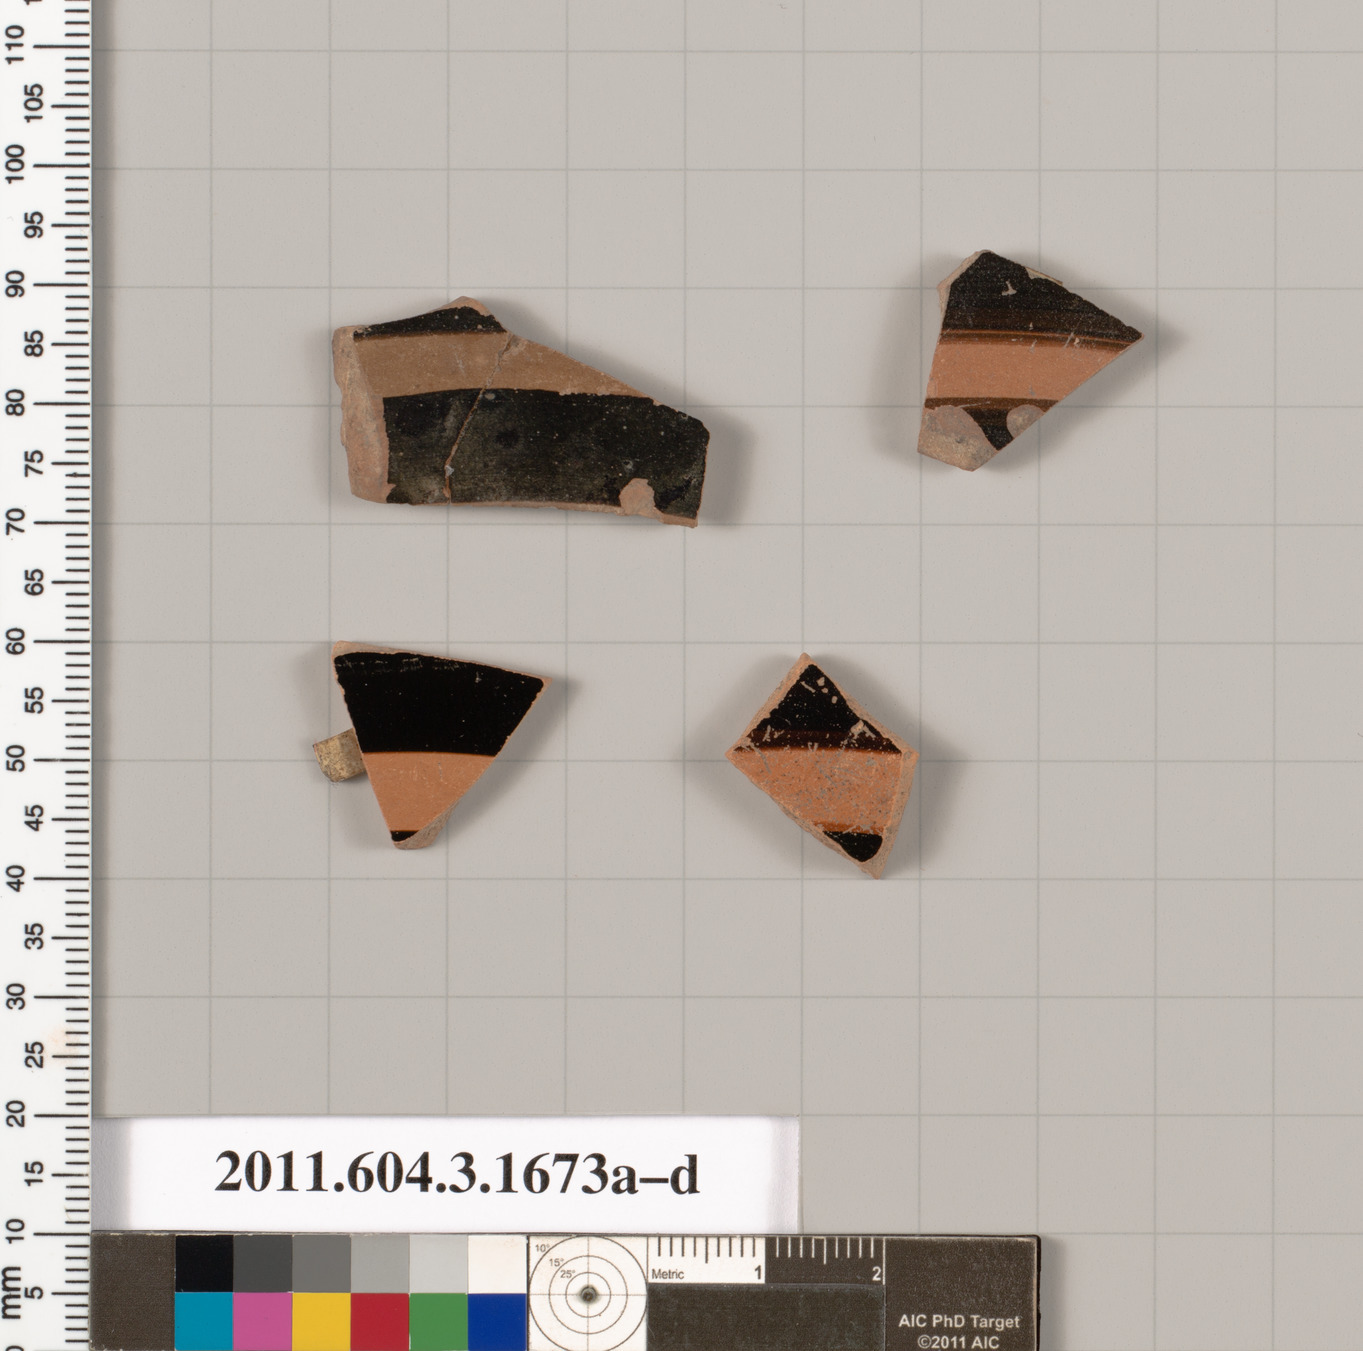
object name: kylix fragment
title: Terracotta fragments of kylikes: Band or lip cups (drinking cups)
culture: greek, attic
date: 550-526 BCE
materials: terracotta